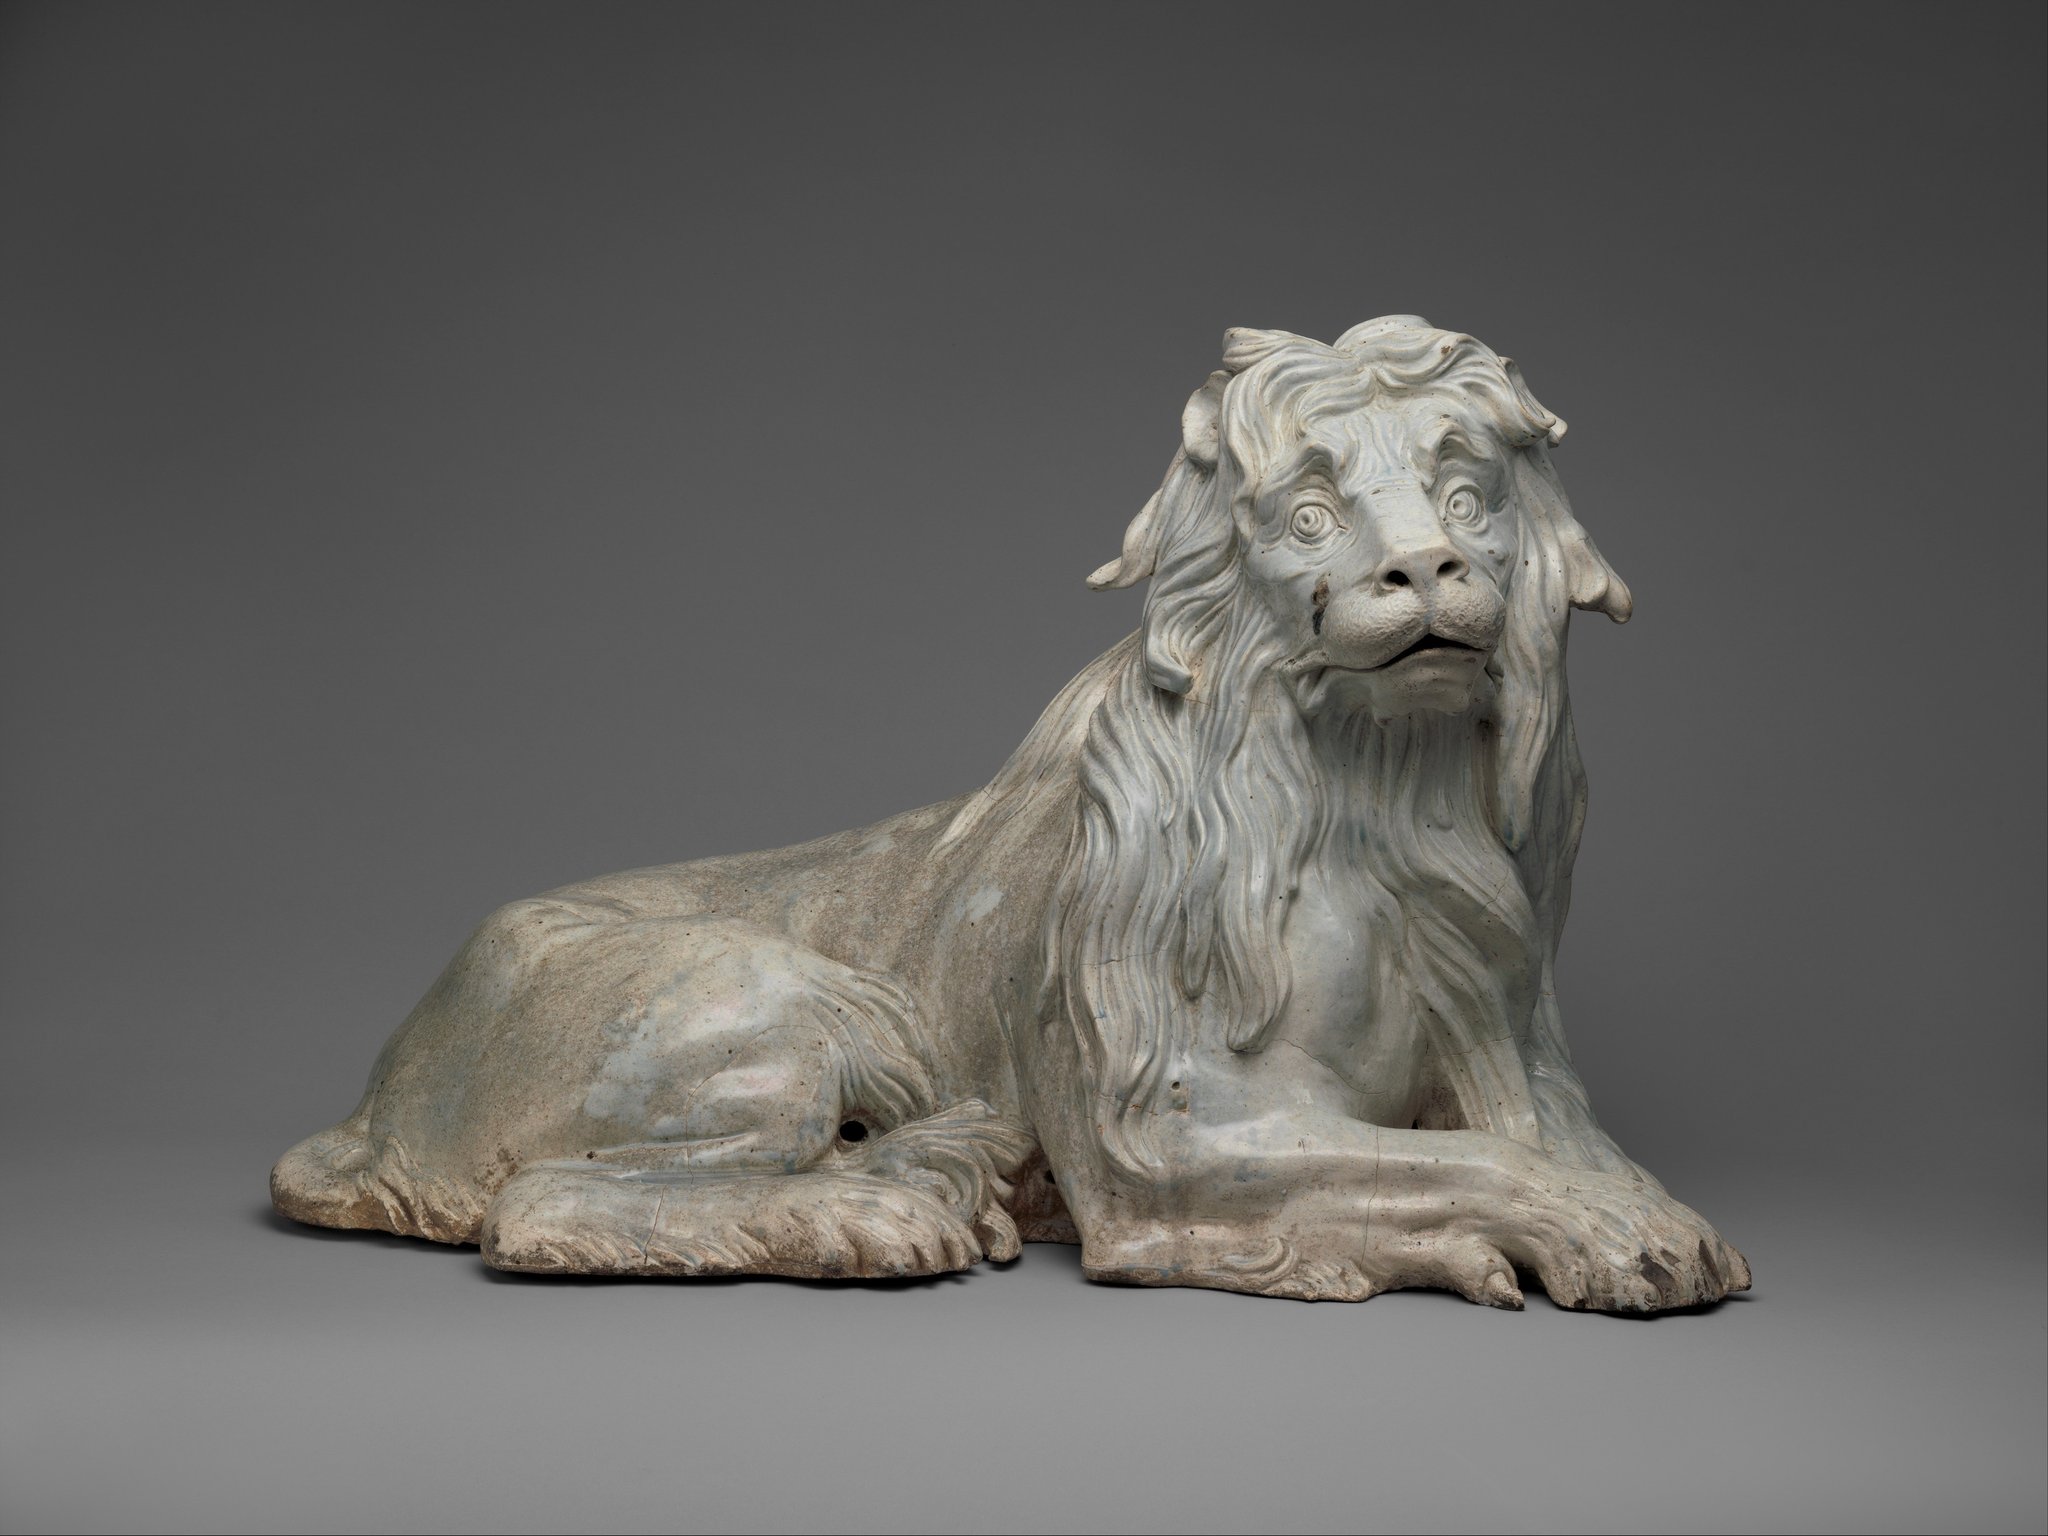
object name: figure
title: Lion (one of a pair)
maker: johann gottlieb kirchner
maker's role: modeler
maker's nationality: german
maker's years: 1706-1738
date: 1732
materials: hard paste porcelain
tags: lions